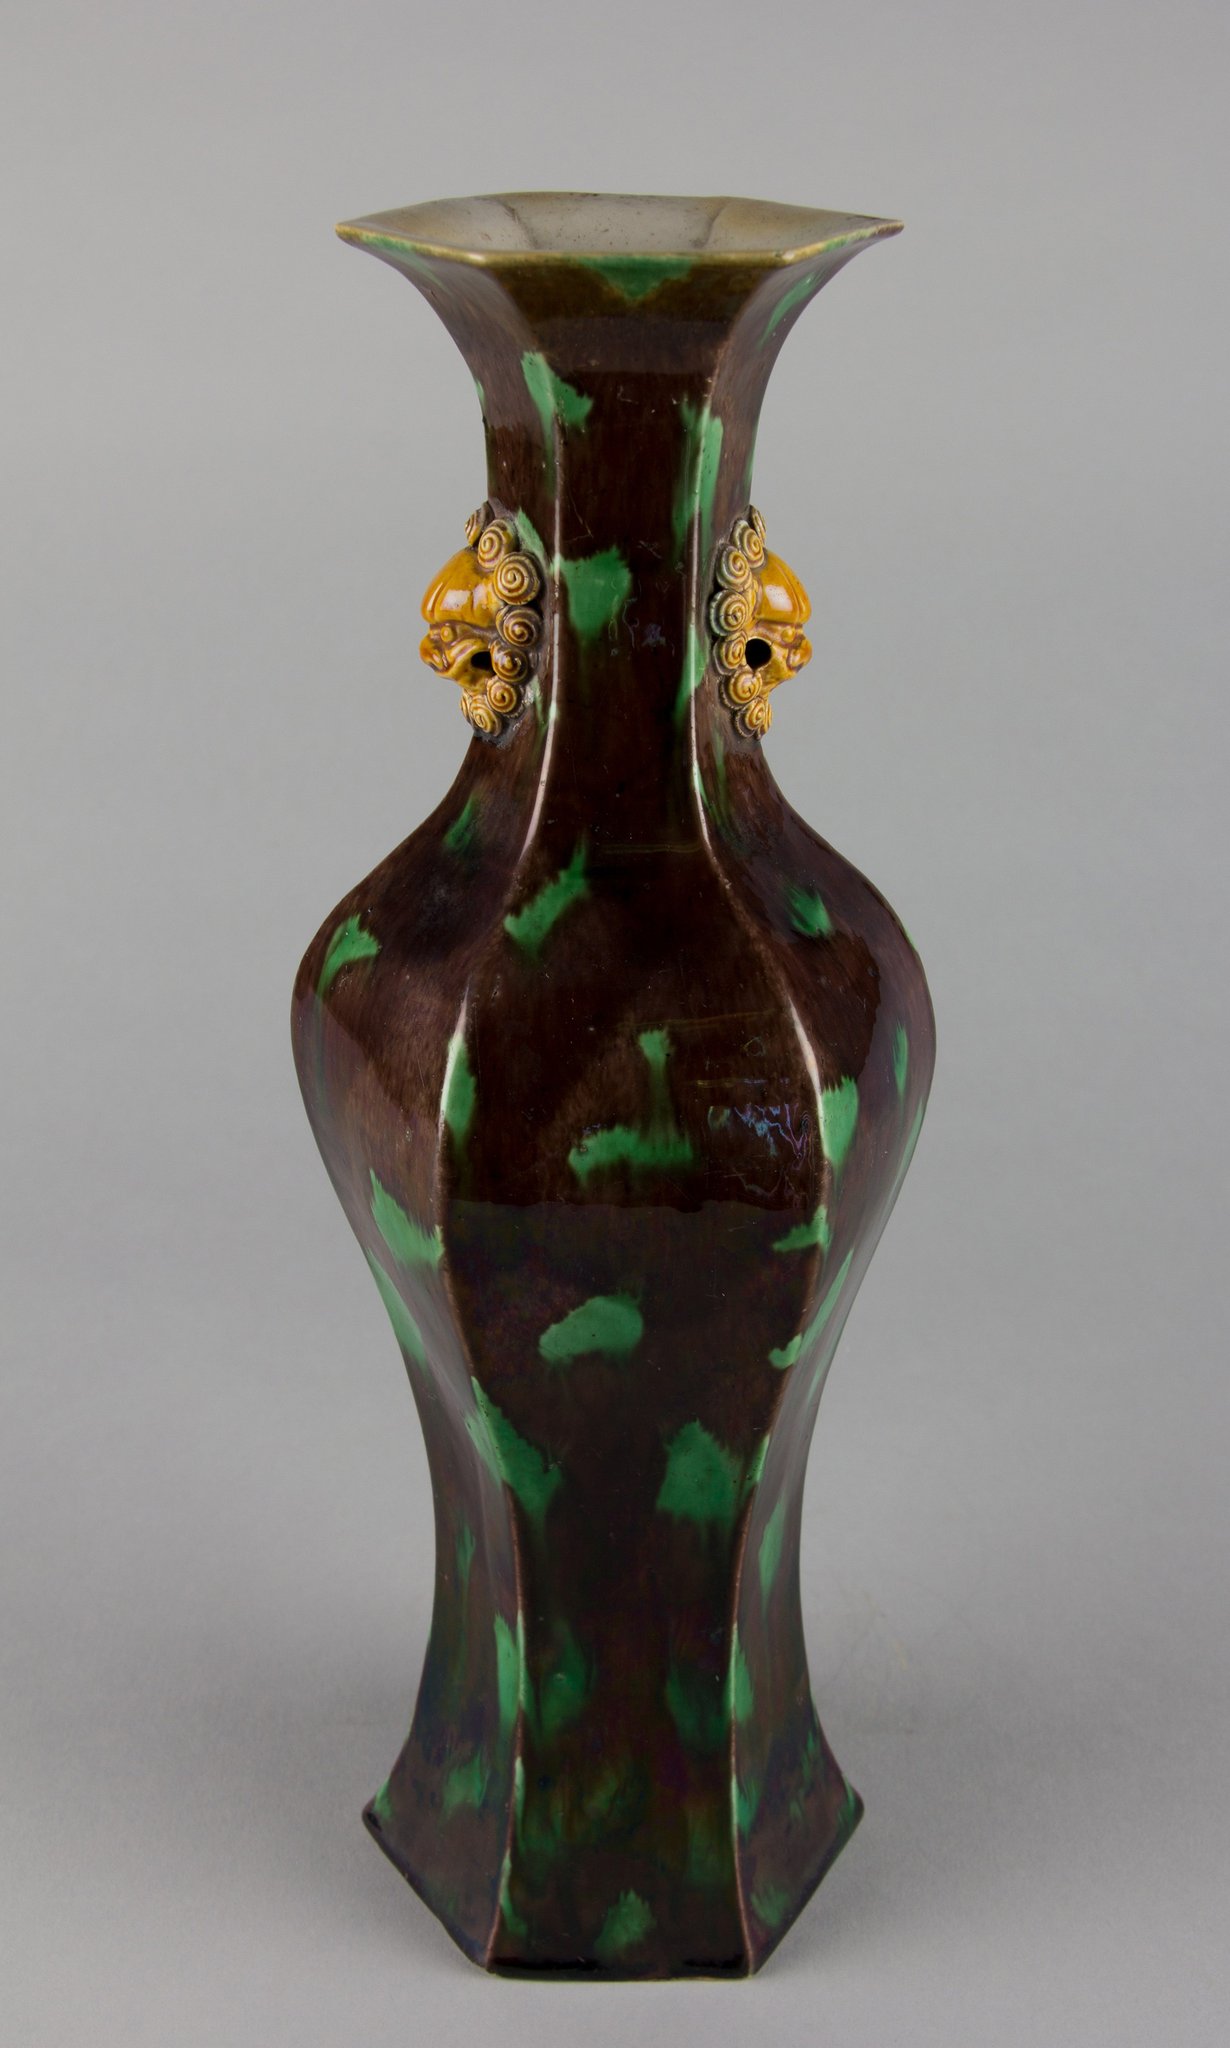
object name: vase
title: Hexagonal vase with lion-head handles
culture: chinese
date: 1567-1633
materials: biscuit, enamel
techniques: polychrome